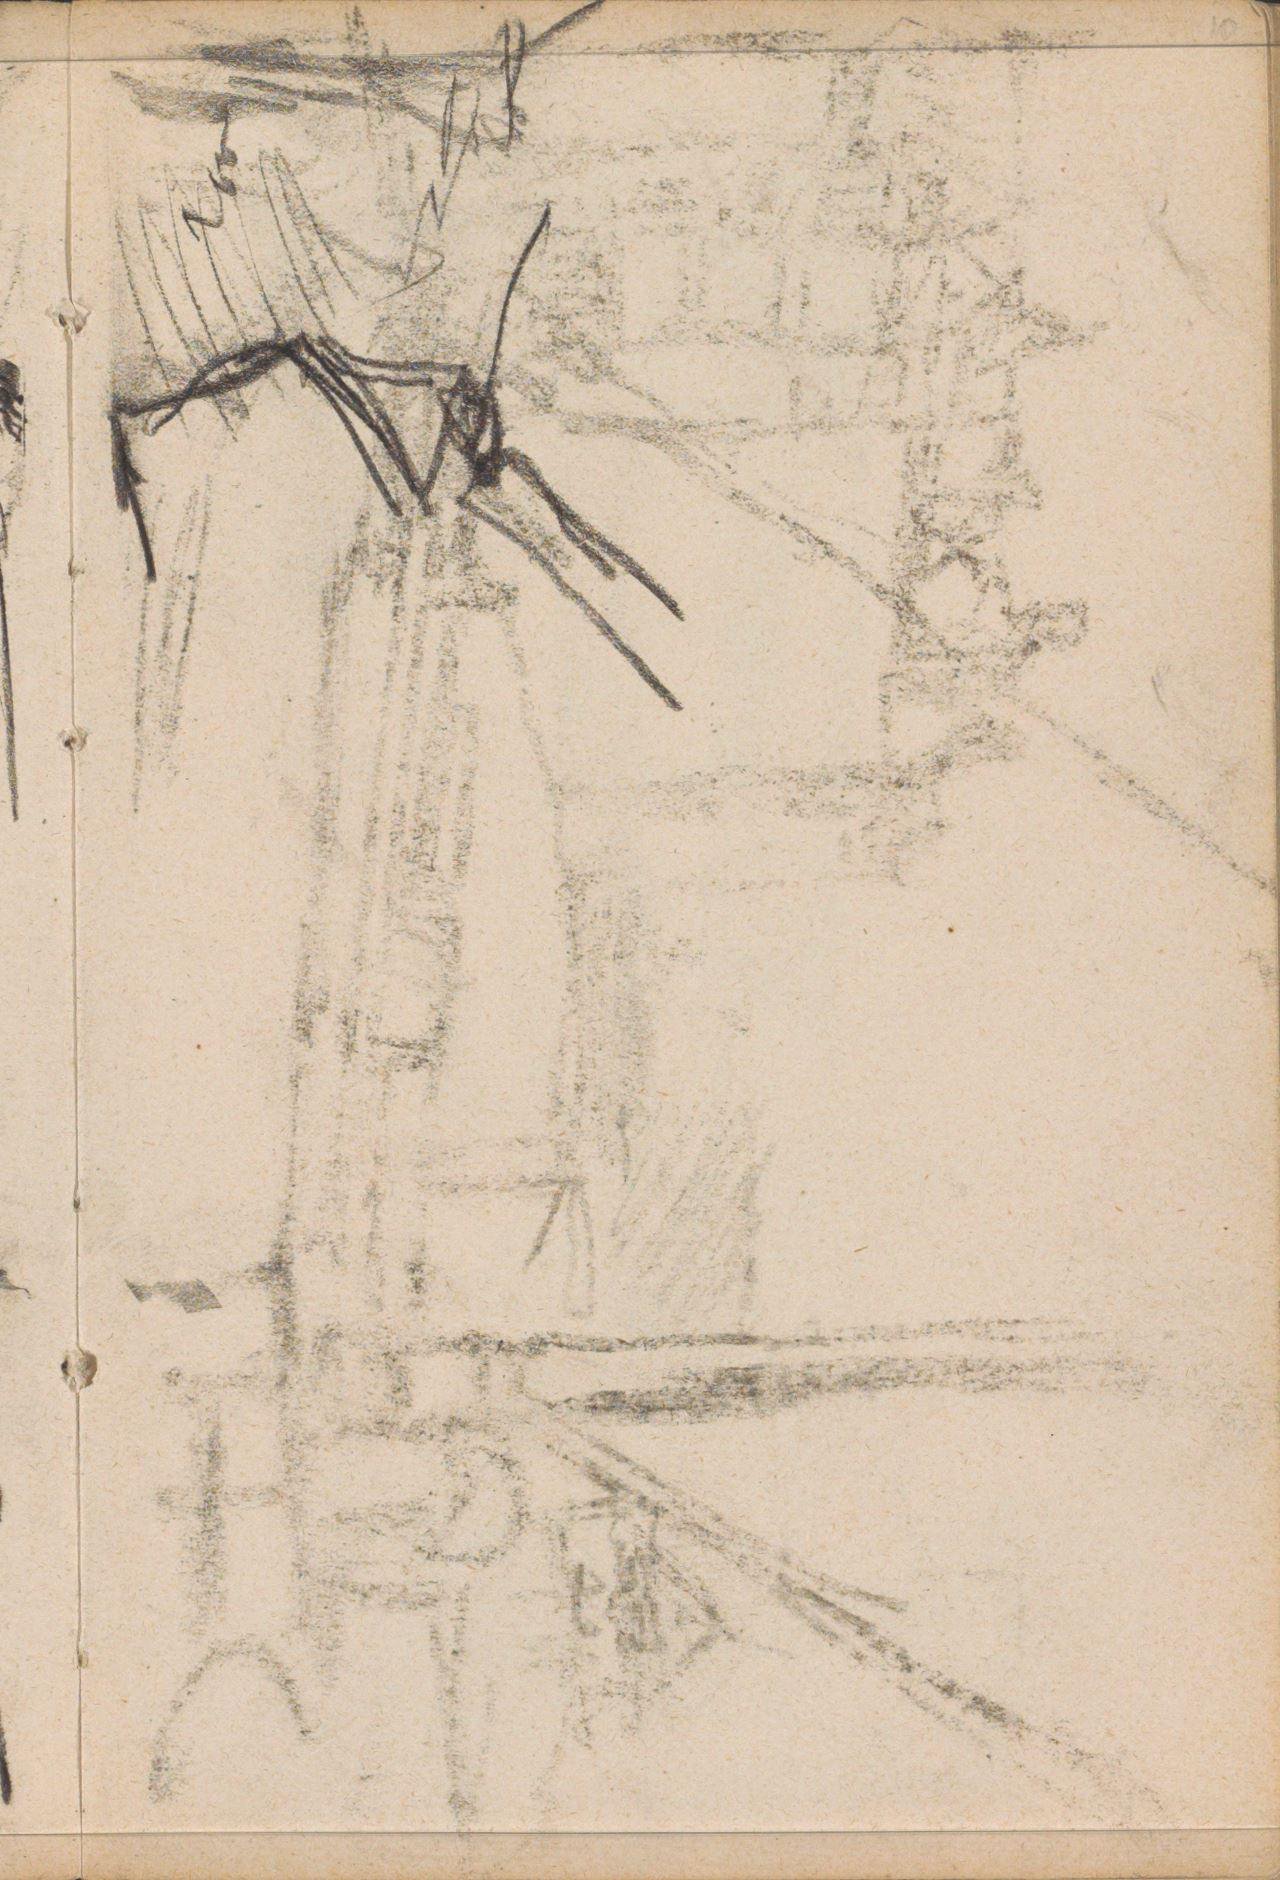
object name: sketchbook leaf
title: Studie, mogelijk van een steven bij een meerpaal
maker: george hendrik breitner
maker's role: draughtsman, painter, print maker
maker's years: 1857-1923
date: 1909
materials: chalk, paper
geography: amsterdam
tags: parts of ship's exterior: bow, mooring-buoy, bollard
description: Studie, mogelijk van een steven bij een meerpaal. Pagina 10 uit een schetsboek met 45 bladen vervaardigd in Amsterdam en Pittsburgh.